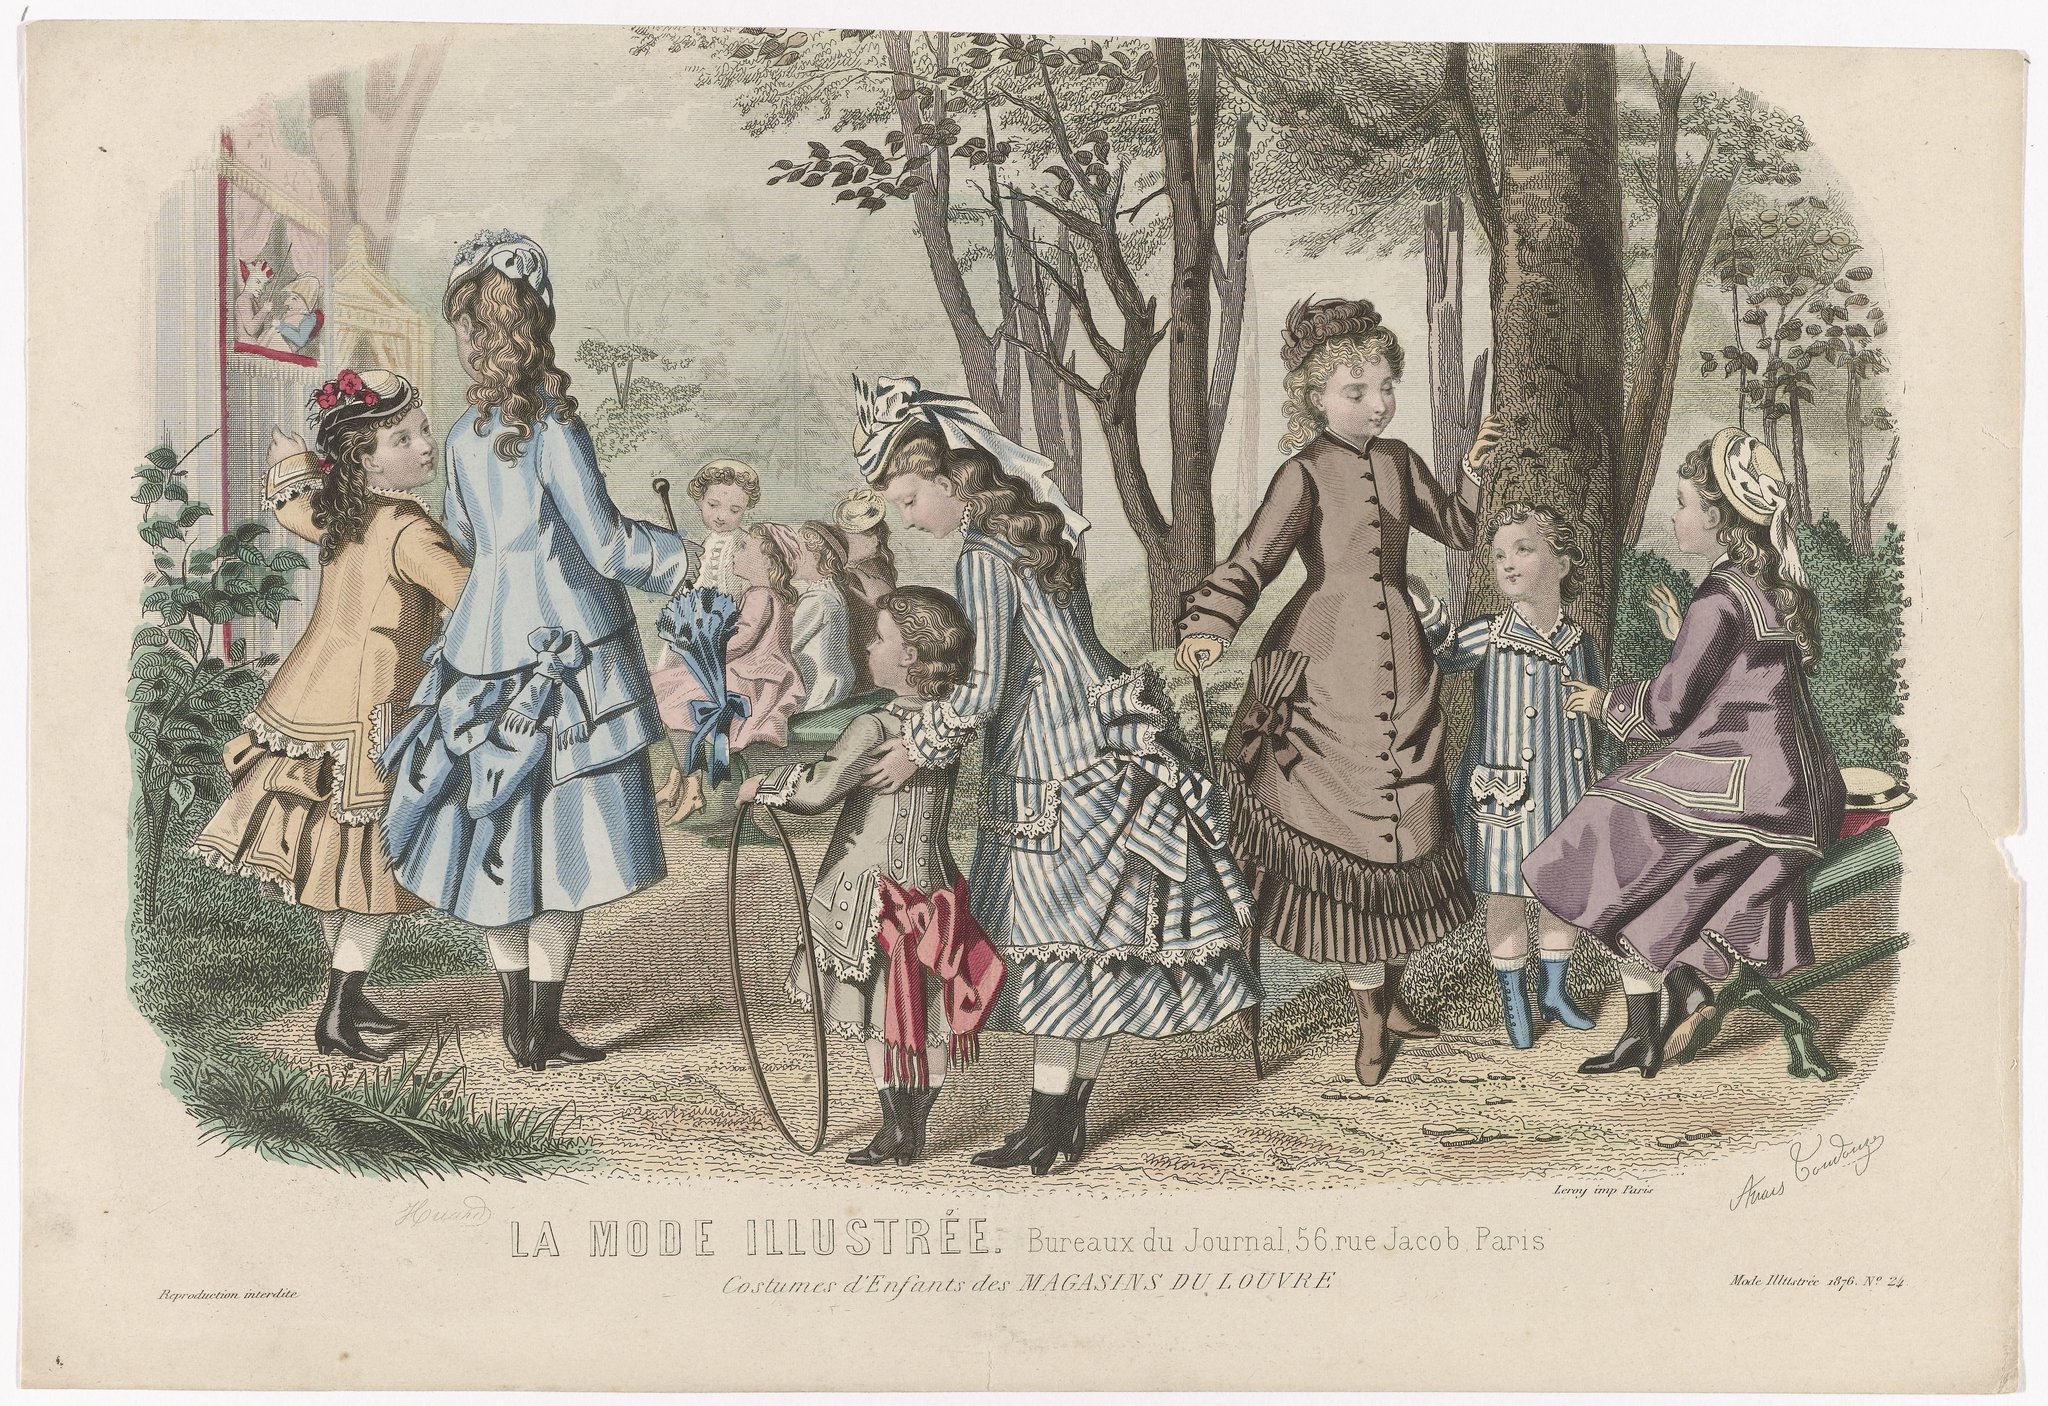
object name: fashion print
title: La Mode Illustrée, 1876, No. 24 : Costumes d'Enfants (...)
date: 1876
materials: paper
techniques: engraving, hand coloring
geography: paris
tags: head-gear (+ girls' clothes), boots (+ girls' clothes), parasol, sunshade (+ girls' clothes), punch and judy, fashion plates, skirt (+ women's clothes), (bowling a) hoop, dress, gown (+ girls' clothes)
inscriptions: address: ‘Bureaux du Journal, 56, Rue Jacob. Paris’, title: ‘La Mode Illustrée’, caption: ‘Costumes d'Enfants des Magasins du Louvre’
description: Zeven kinderen spelen buiten, gekleed in kledij van het warenhuis Grands Magasins du Louvre. De rokken van de japonnen zijn aan de achterkant opgetrokken en vastgezet met strikken.Prent uit het modetijdschrift La Mode Illustrée (1860-1937).